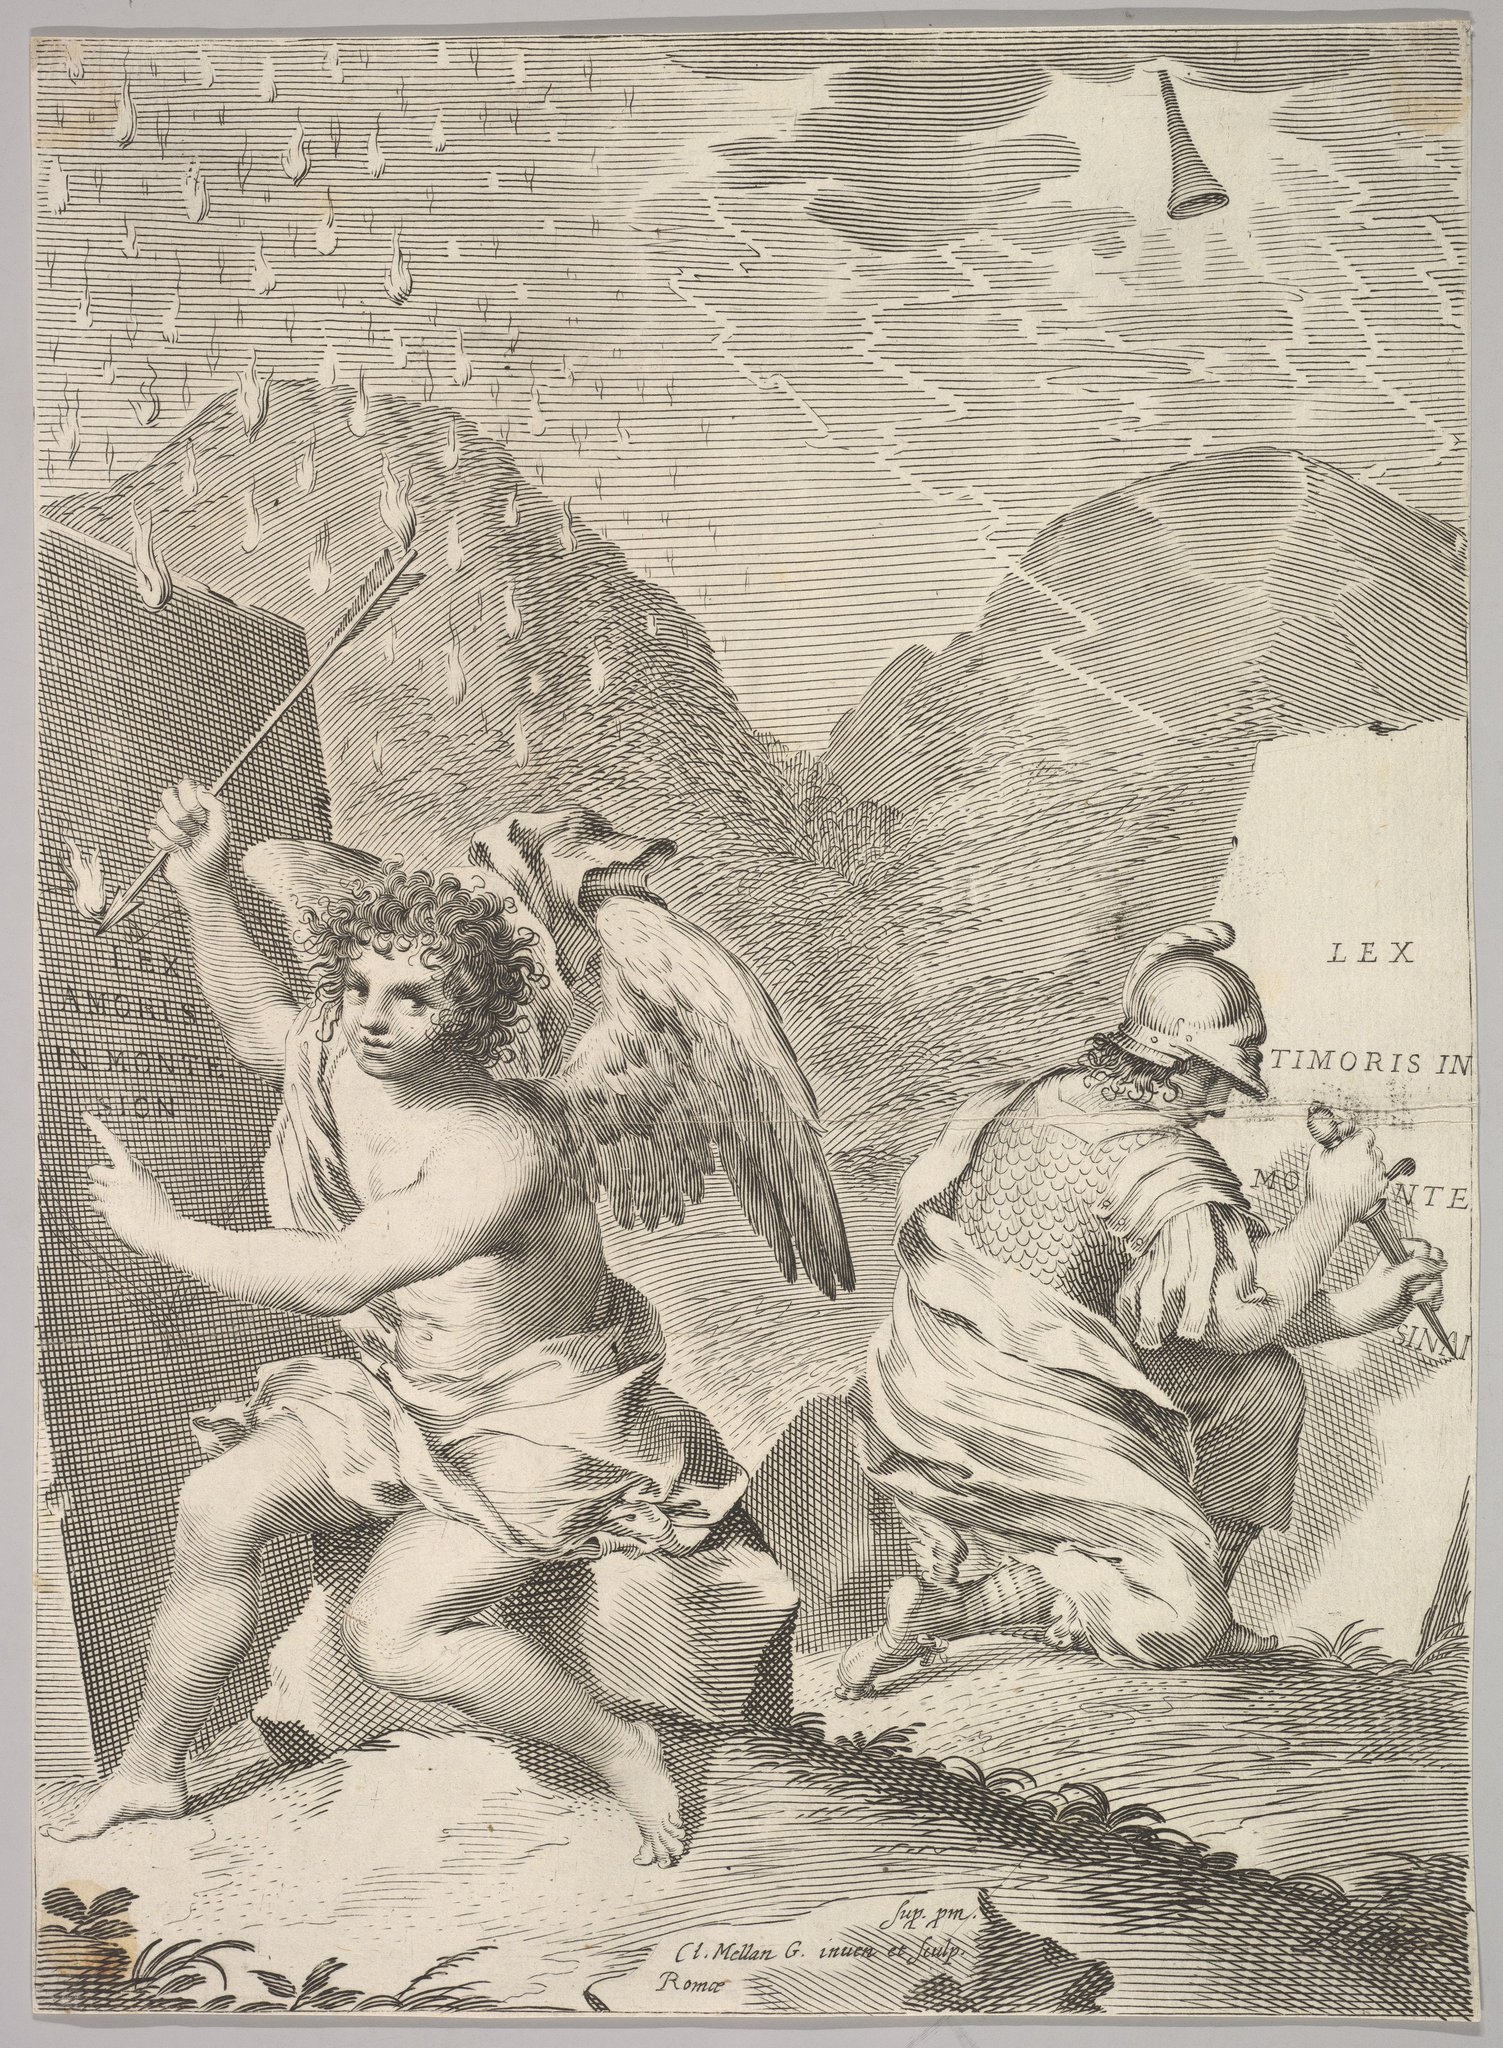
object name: print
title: An Angel and a Soldier Inscribe Stone Slabs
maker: claude mellan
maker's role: artist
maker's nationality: french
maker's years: 1598-1688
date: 1624-1636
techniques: engraving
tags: arrows,angels